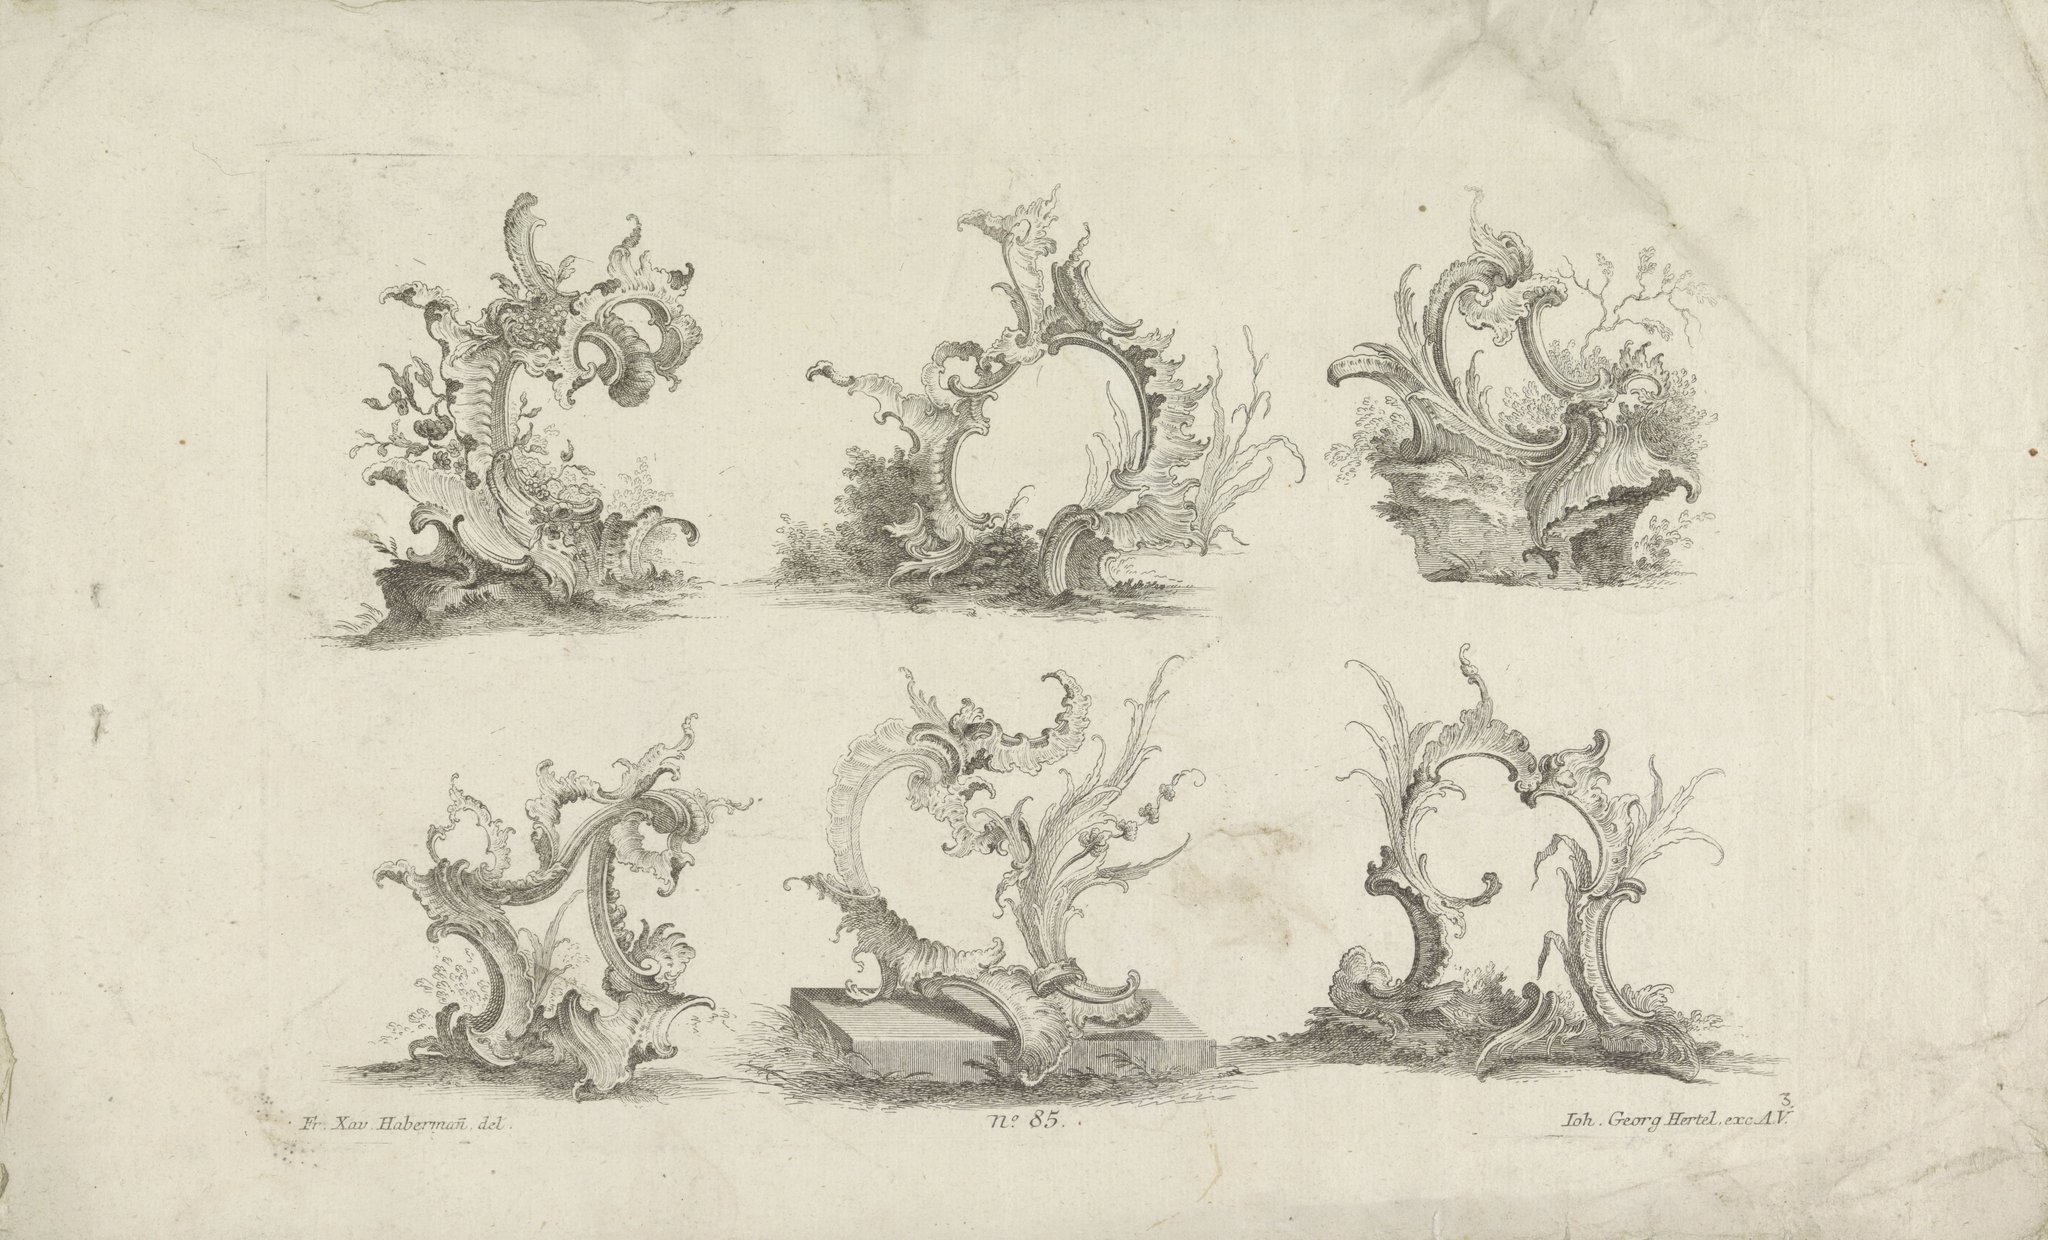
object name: print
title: Rocailles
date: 1731-1775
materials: paper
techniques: etching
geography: augsburg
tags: rocaille ornament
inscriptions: collector's mark: Lugt 2228, collector's mark: Lugt 2760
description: Zes rocaille ornamenten. Uitgeversnummer 85.